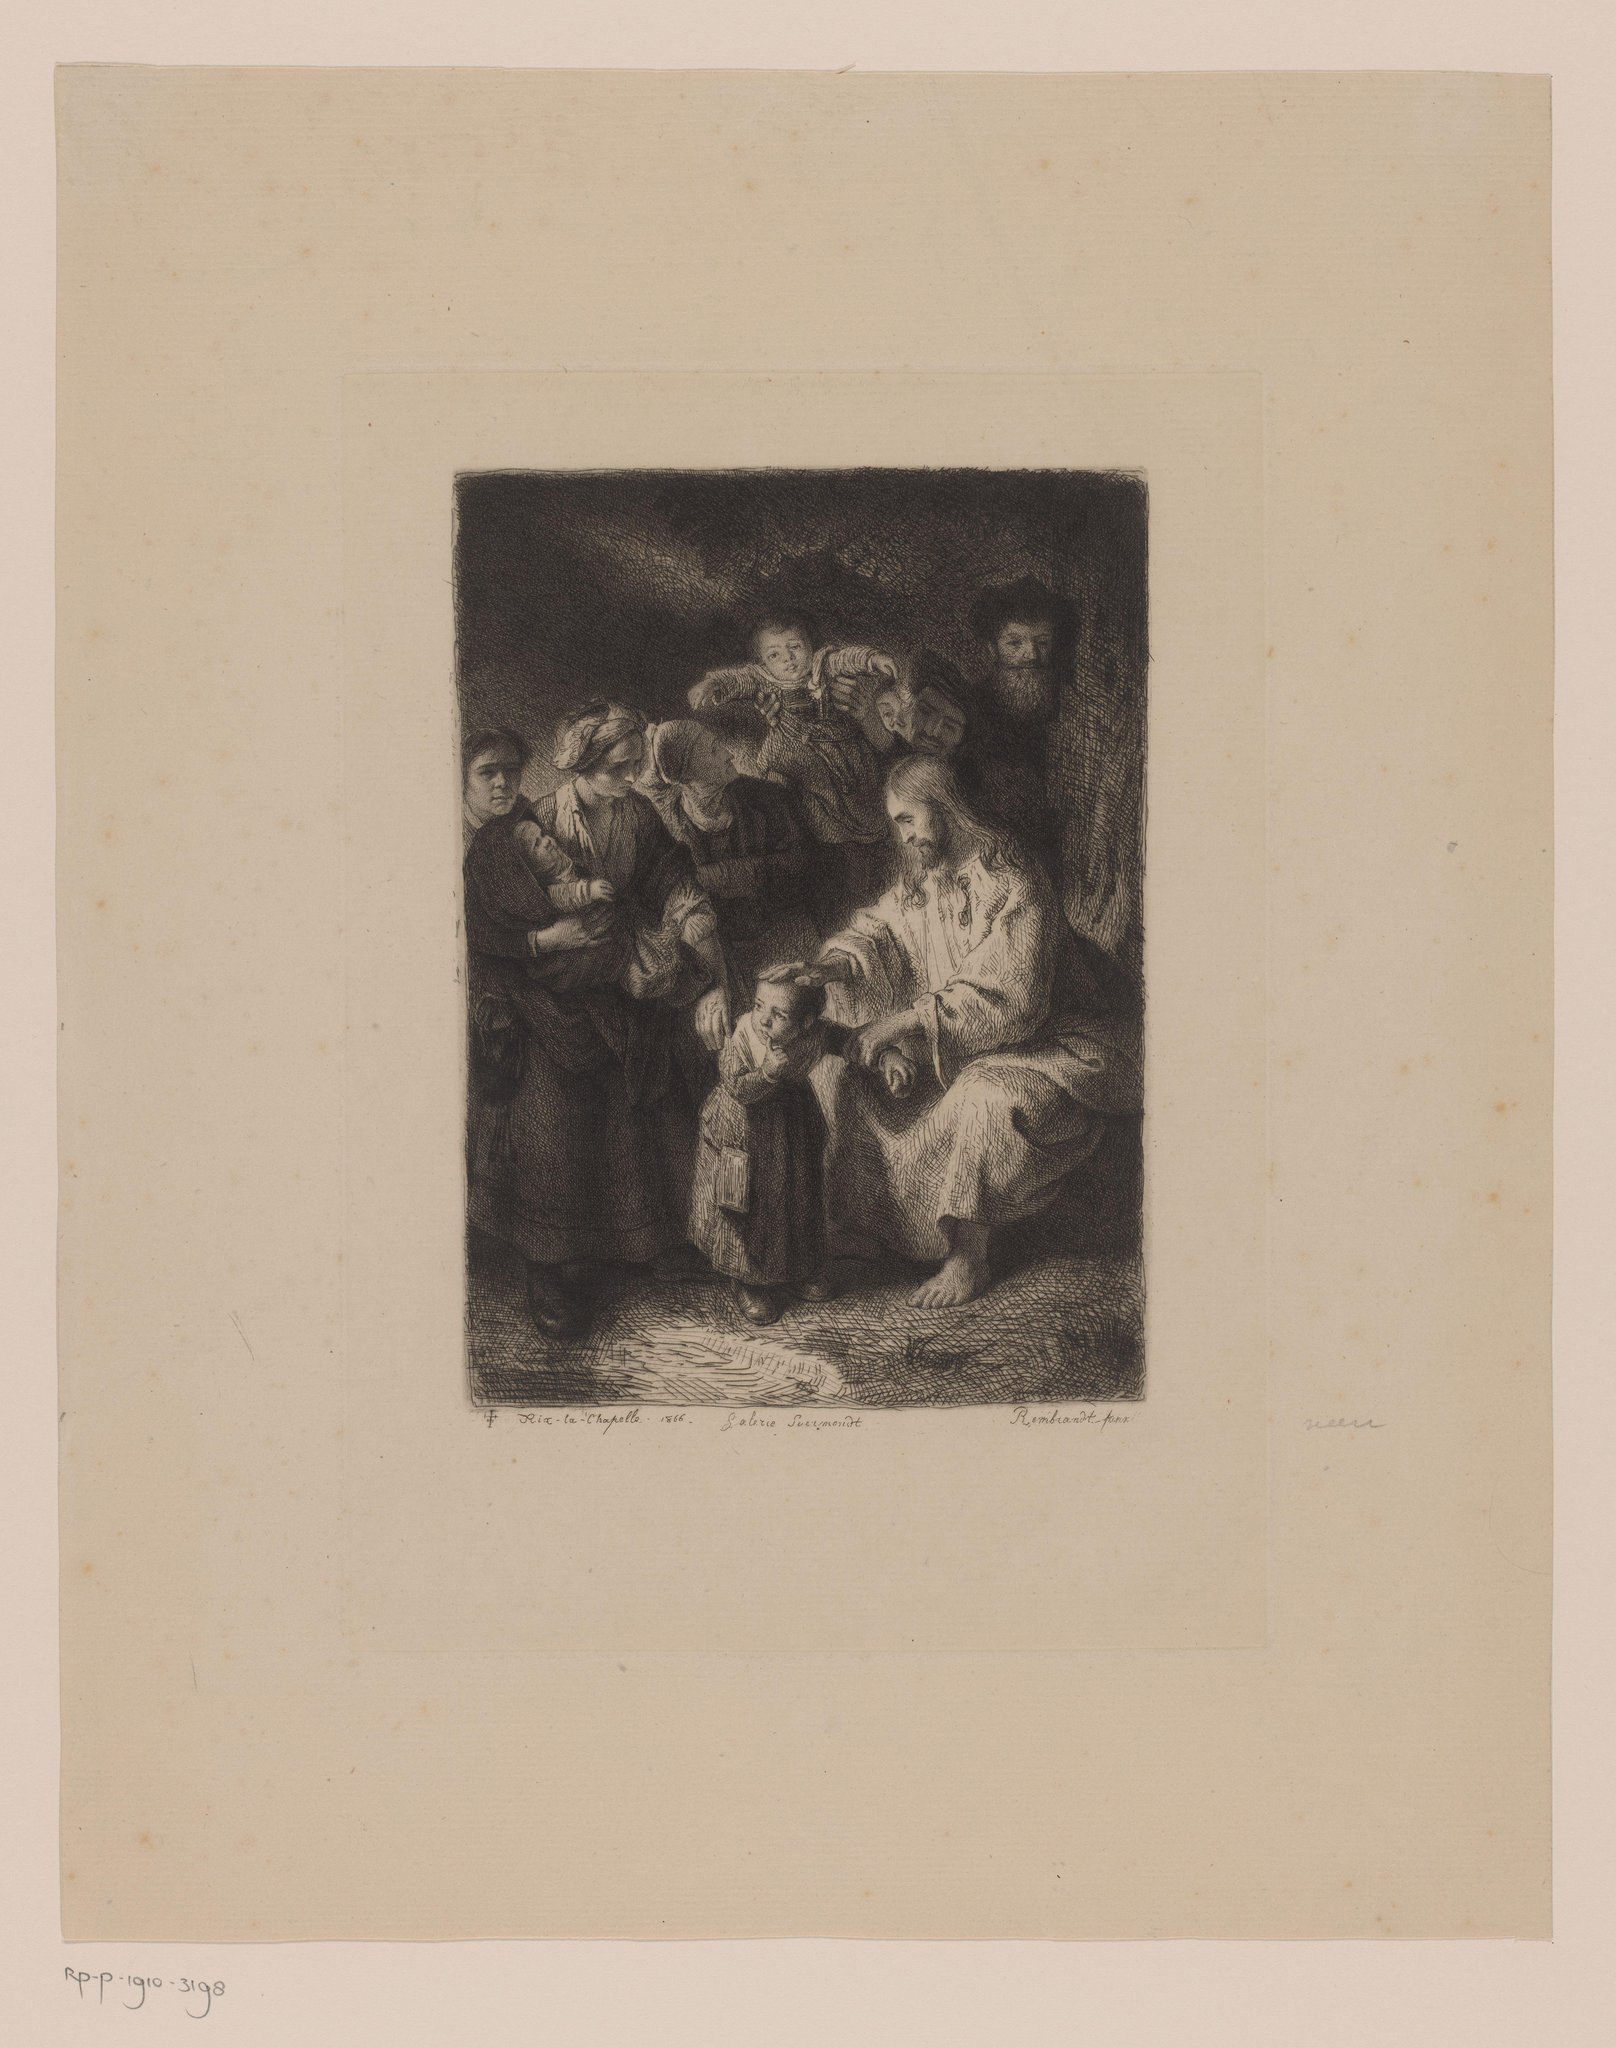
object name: print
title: Christus zegent de kinderen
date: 1866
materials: paper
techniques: drypoint, etching, intaglio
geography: aachen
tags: christ blessing children brought by their mothers, usually with some disciples disapprovingly looking on (matthew 19:13-15; mark 10:13-16; luke 18:15-17)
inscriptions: collector's mark: Lugt 2228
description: Prent uit: Gazette des beaux-arts (1866), dl. 2, p. 254-255.